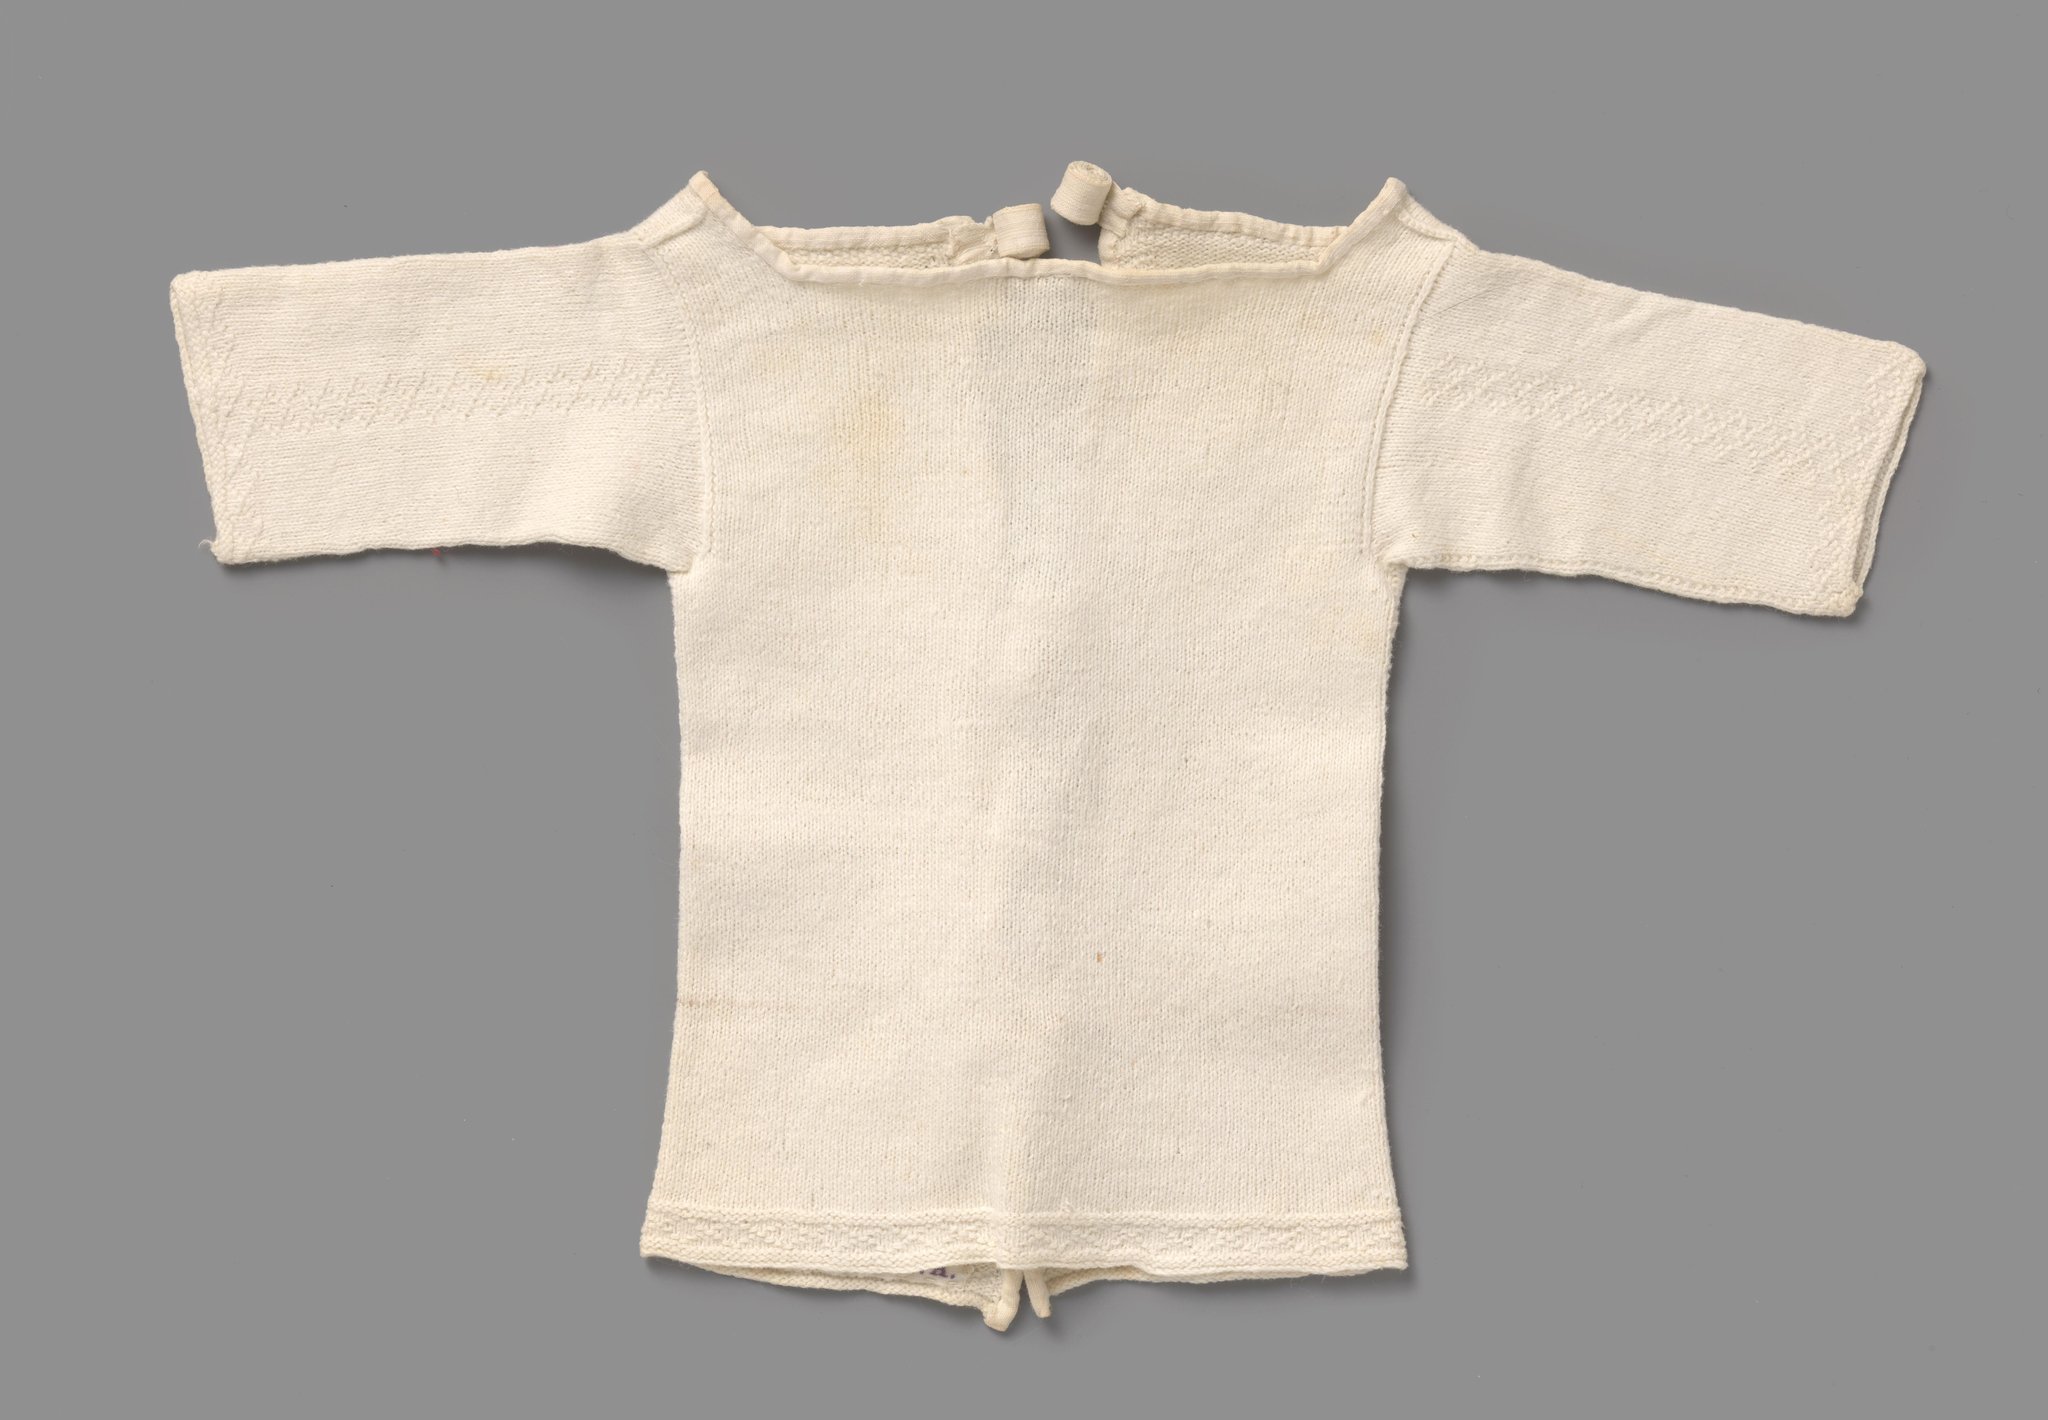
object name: childrenswear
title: Gebreide borstrok van wit katoen, met tricotsteek en kruisranden en driemaal twee strikbanden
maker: Anonymous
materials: cotton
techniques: knitting